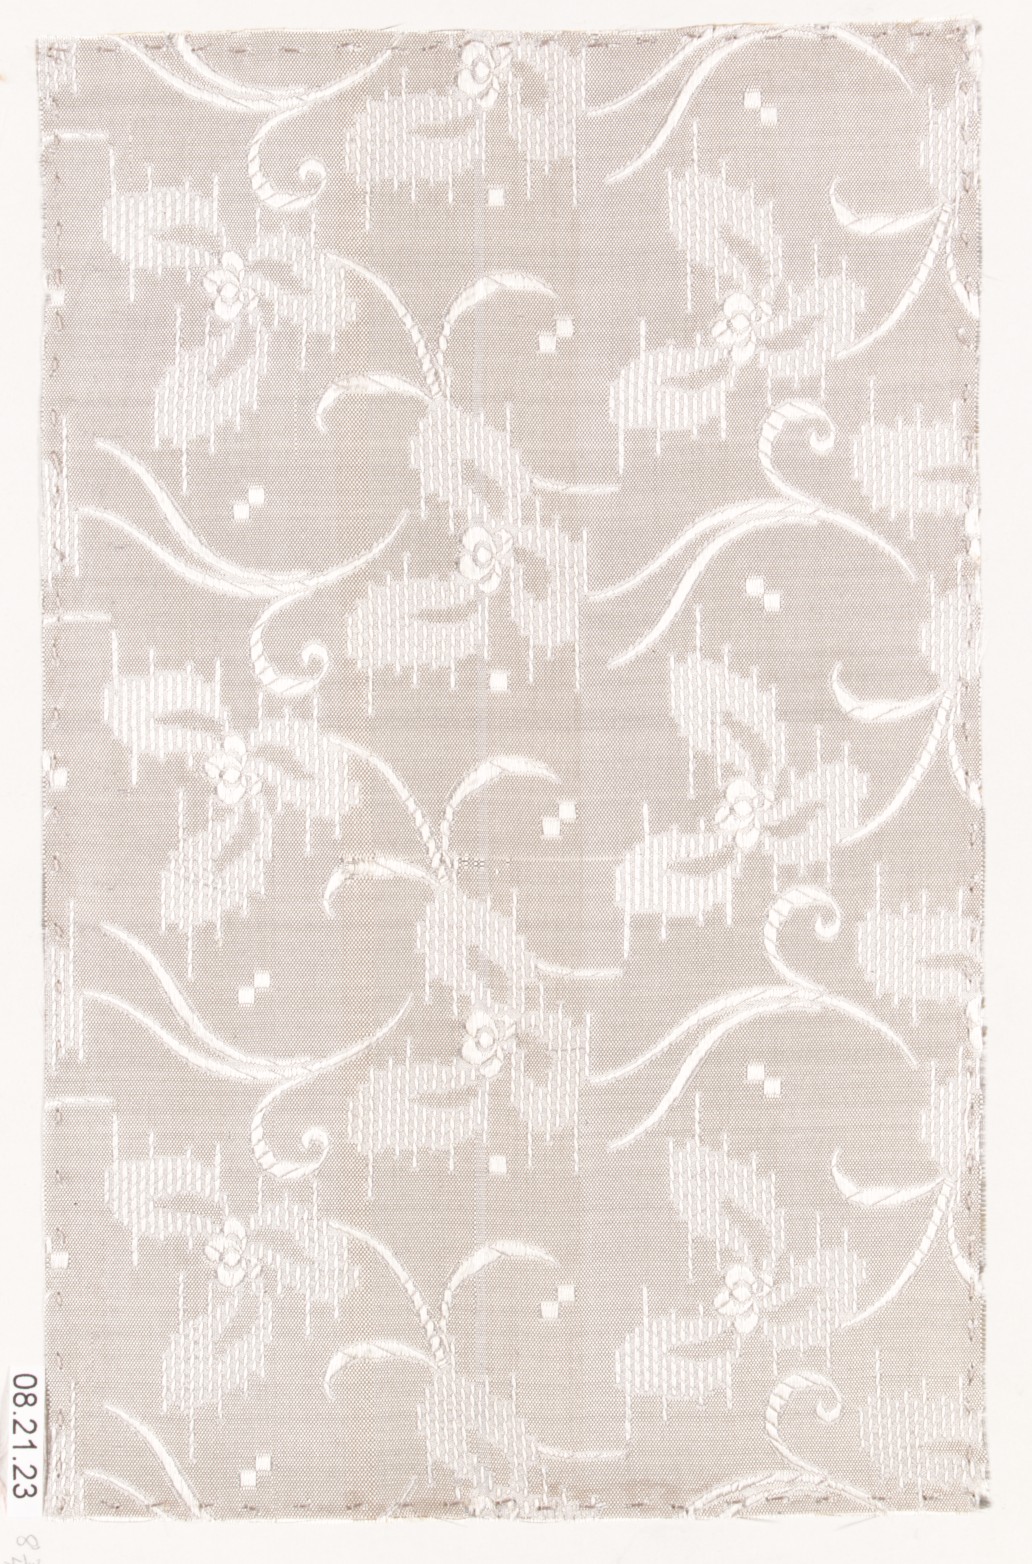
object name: textile sample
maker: Anonymous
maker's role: designer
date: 1900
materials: silk